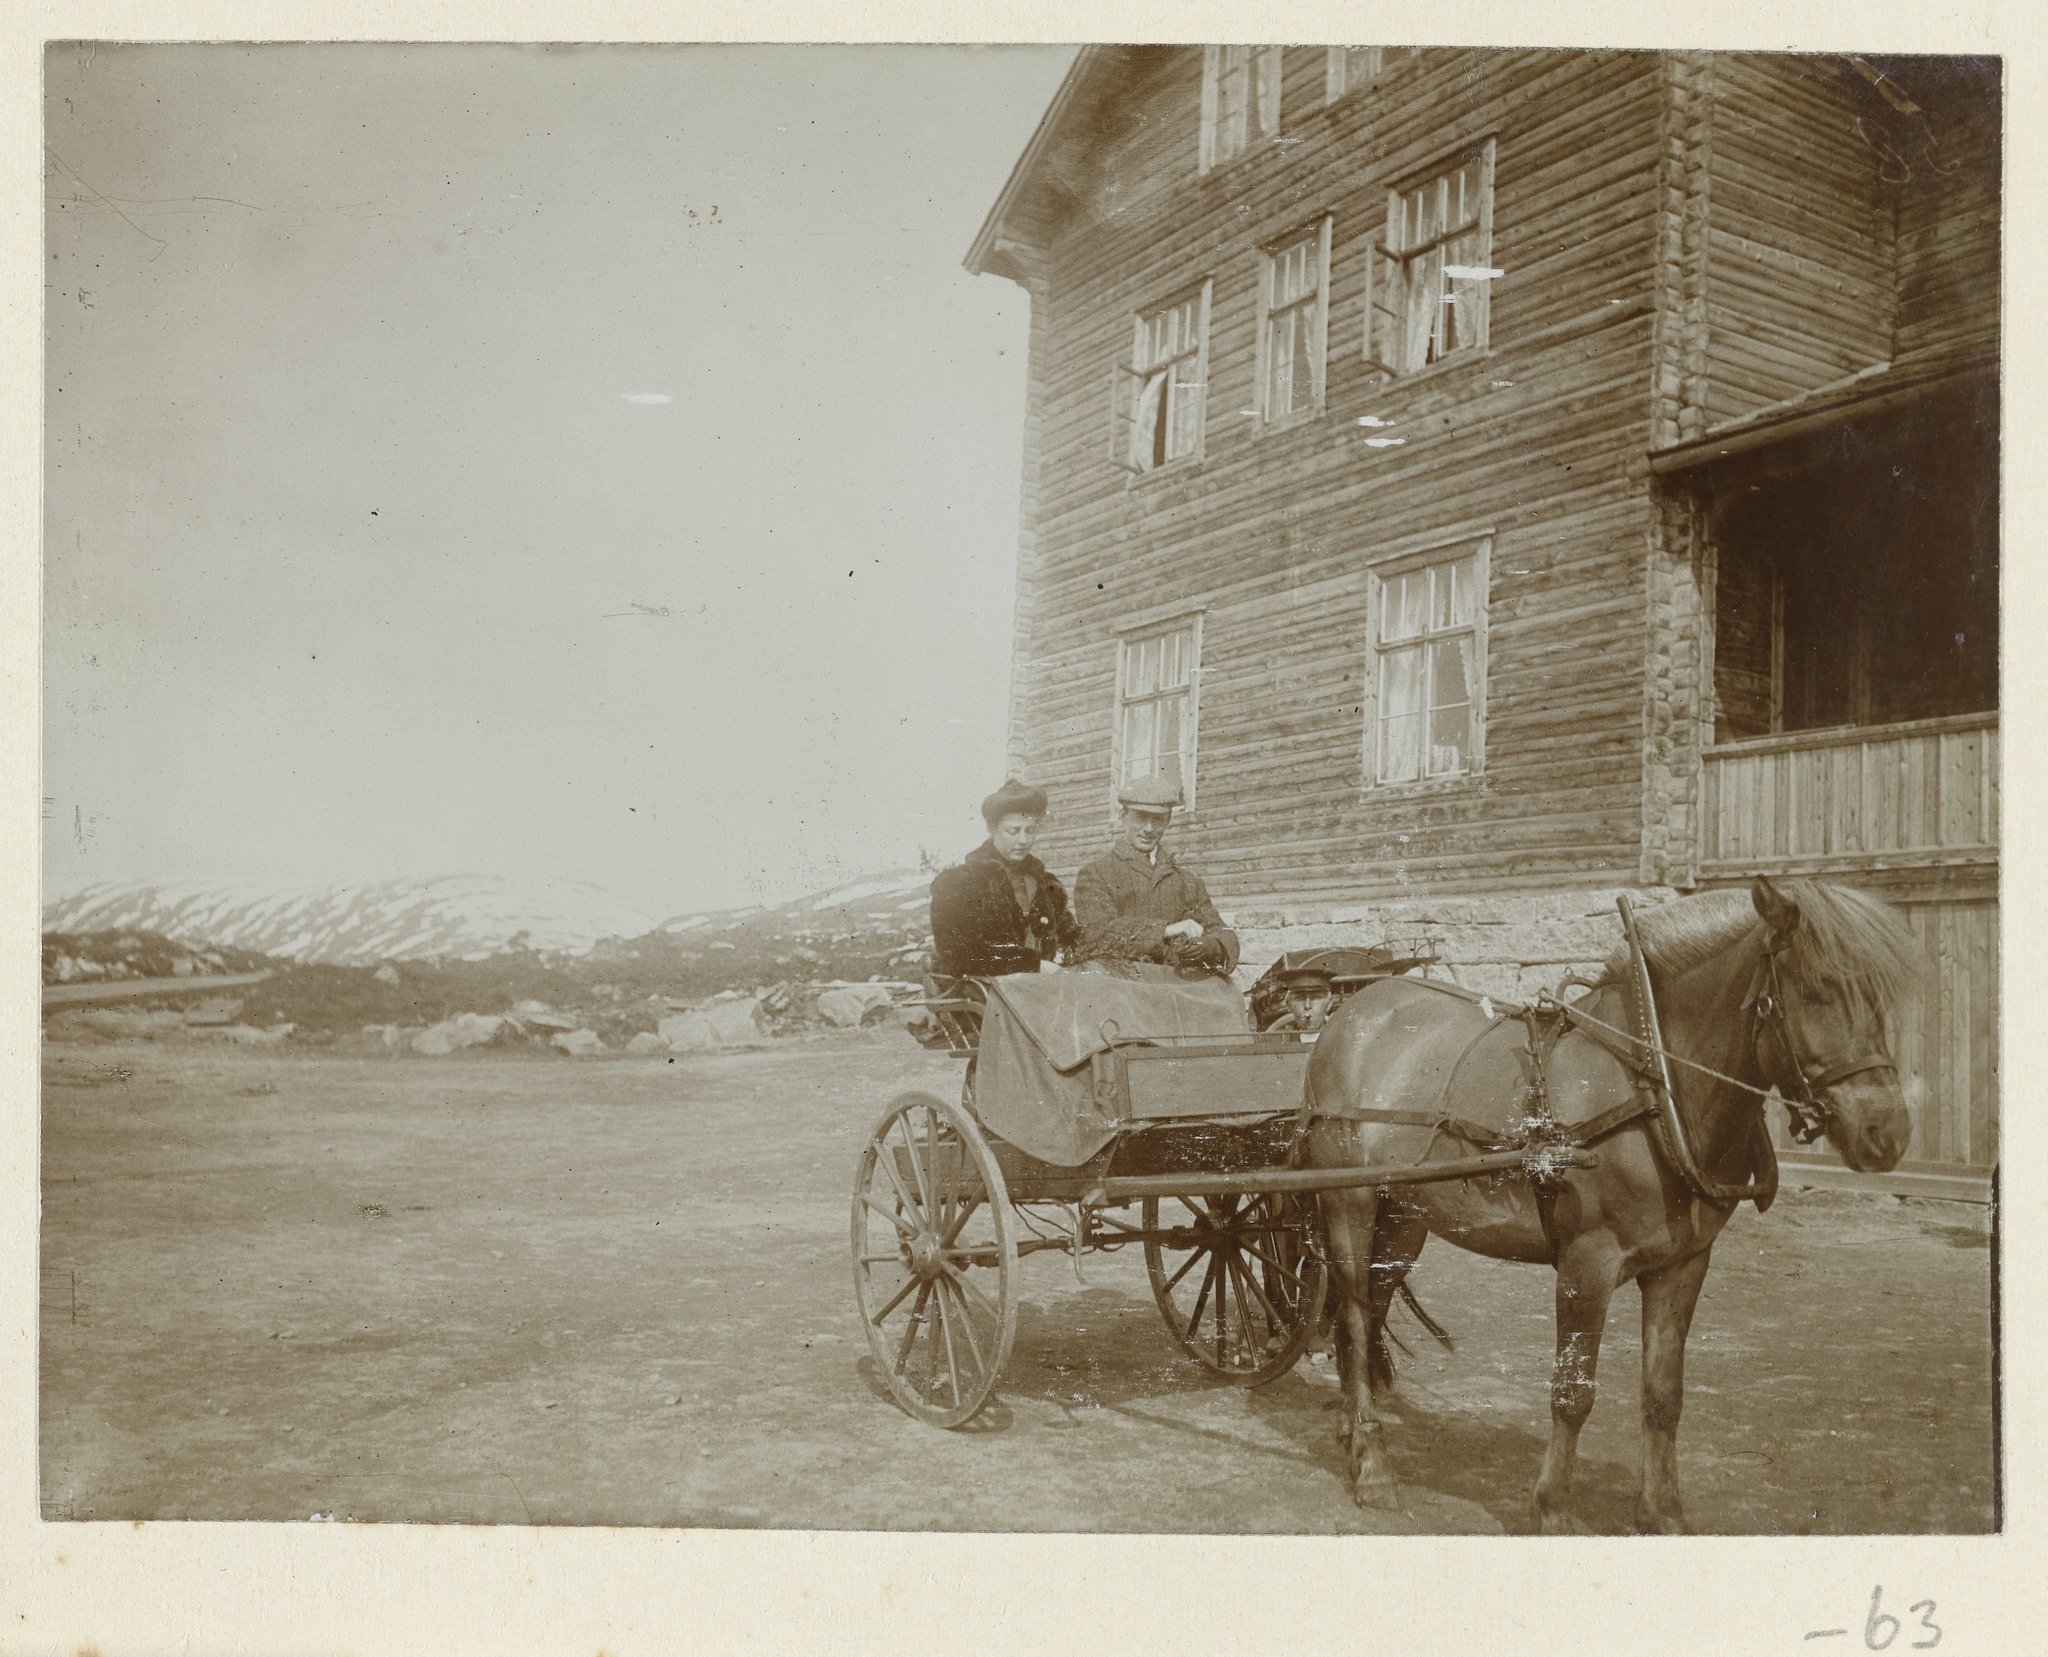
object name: photograph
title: Een echtpaar in een rijtuig voor een houten huis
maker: geldolph adriaan kessler (dolph)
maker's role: fotograaf, industrieel, voetballer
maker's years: 1884-1945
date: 1903-1908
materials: cardboard, photographic support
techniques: gelatin silver print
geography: harz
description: Een echtpaar in een rijtuig voor een houten huis, vermoedelijk in de Harz. Onderdeel van het fotoalbum van Dolph Kessler met opnamen die hij maakte tijdens zijn verblijf in Engeland en op een wereldreis die hij als secretaris van Henri Deterding (directeur Koninklijke Olie) ondernam naar Nederlands-Indië, Japan, China en de Verenigde Staten, tussen 1906 en 1908.